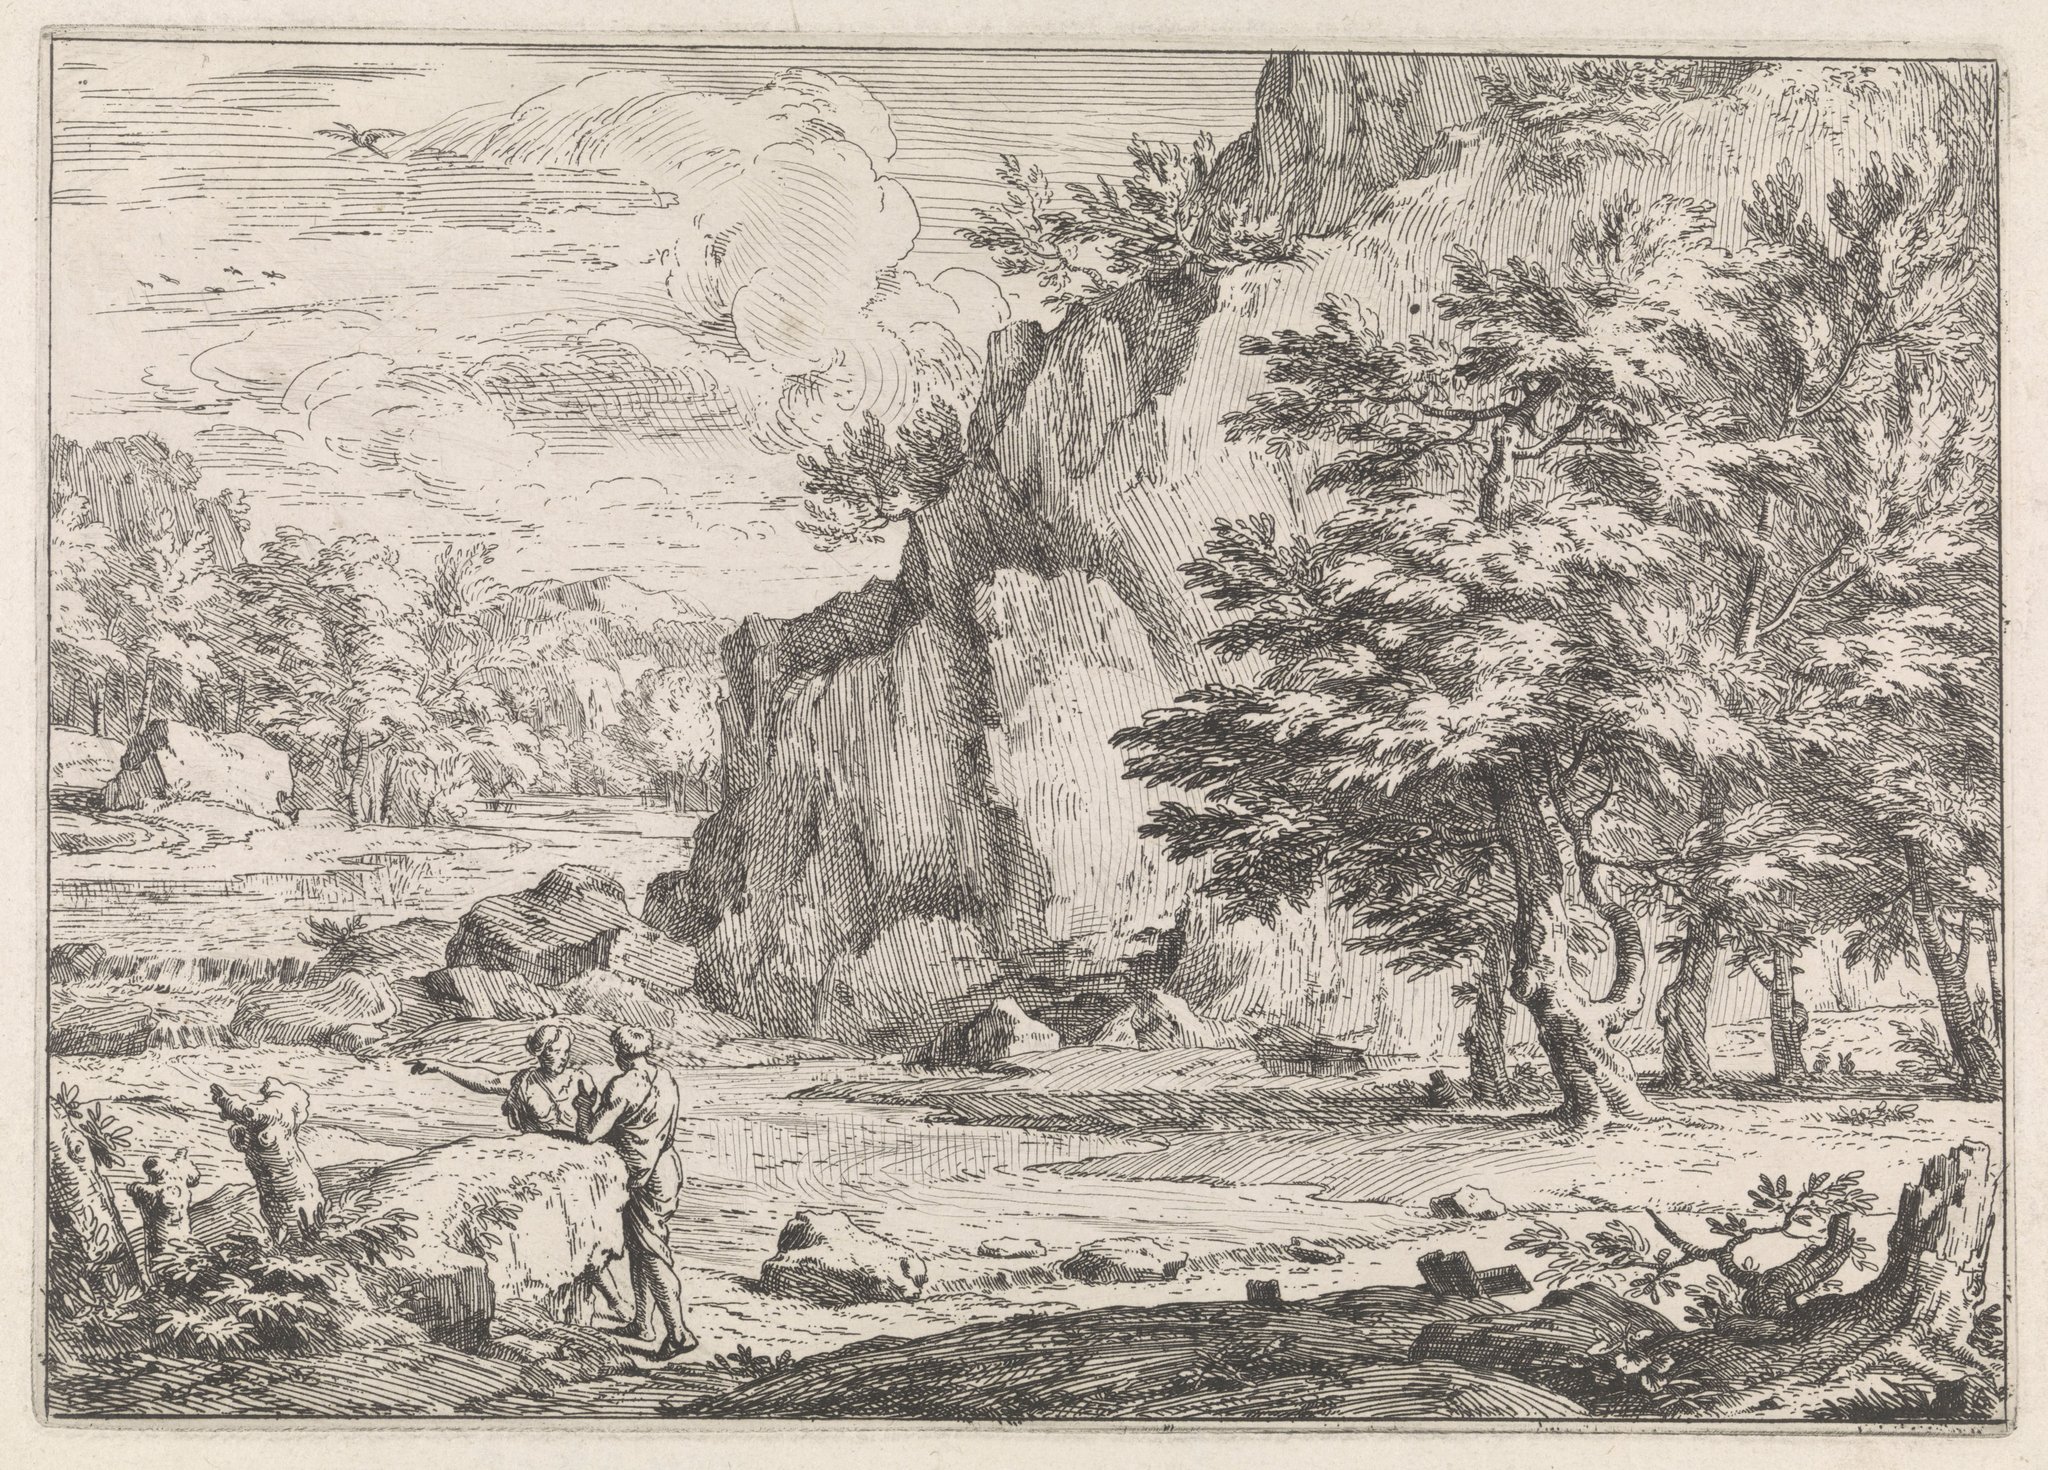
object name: print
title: Landschap met rots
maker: abraham genoels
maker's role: draughtsman, print maker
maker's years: 1640-1723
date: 1650-1723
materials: paper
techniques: etching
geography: paris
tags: rocks, (high) hill (+ landscape with figures, staffage)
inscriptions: collector's mark: Lugt 240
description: Een heuvelachtig landschap met centraal een grote rotswand. Linksvoor twee figuren.